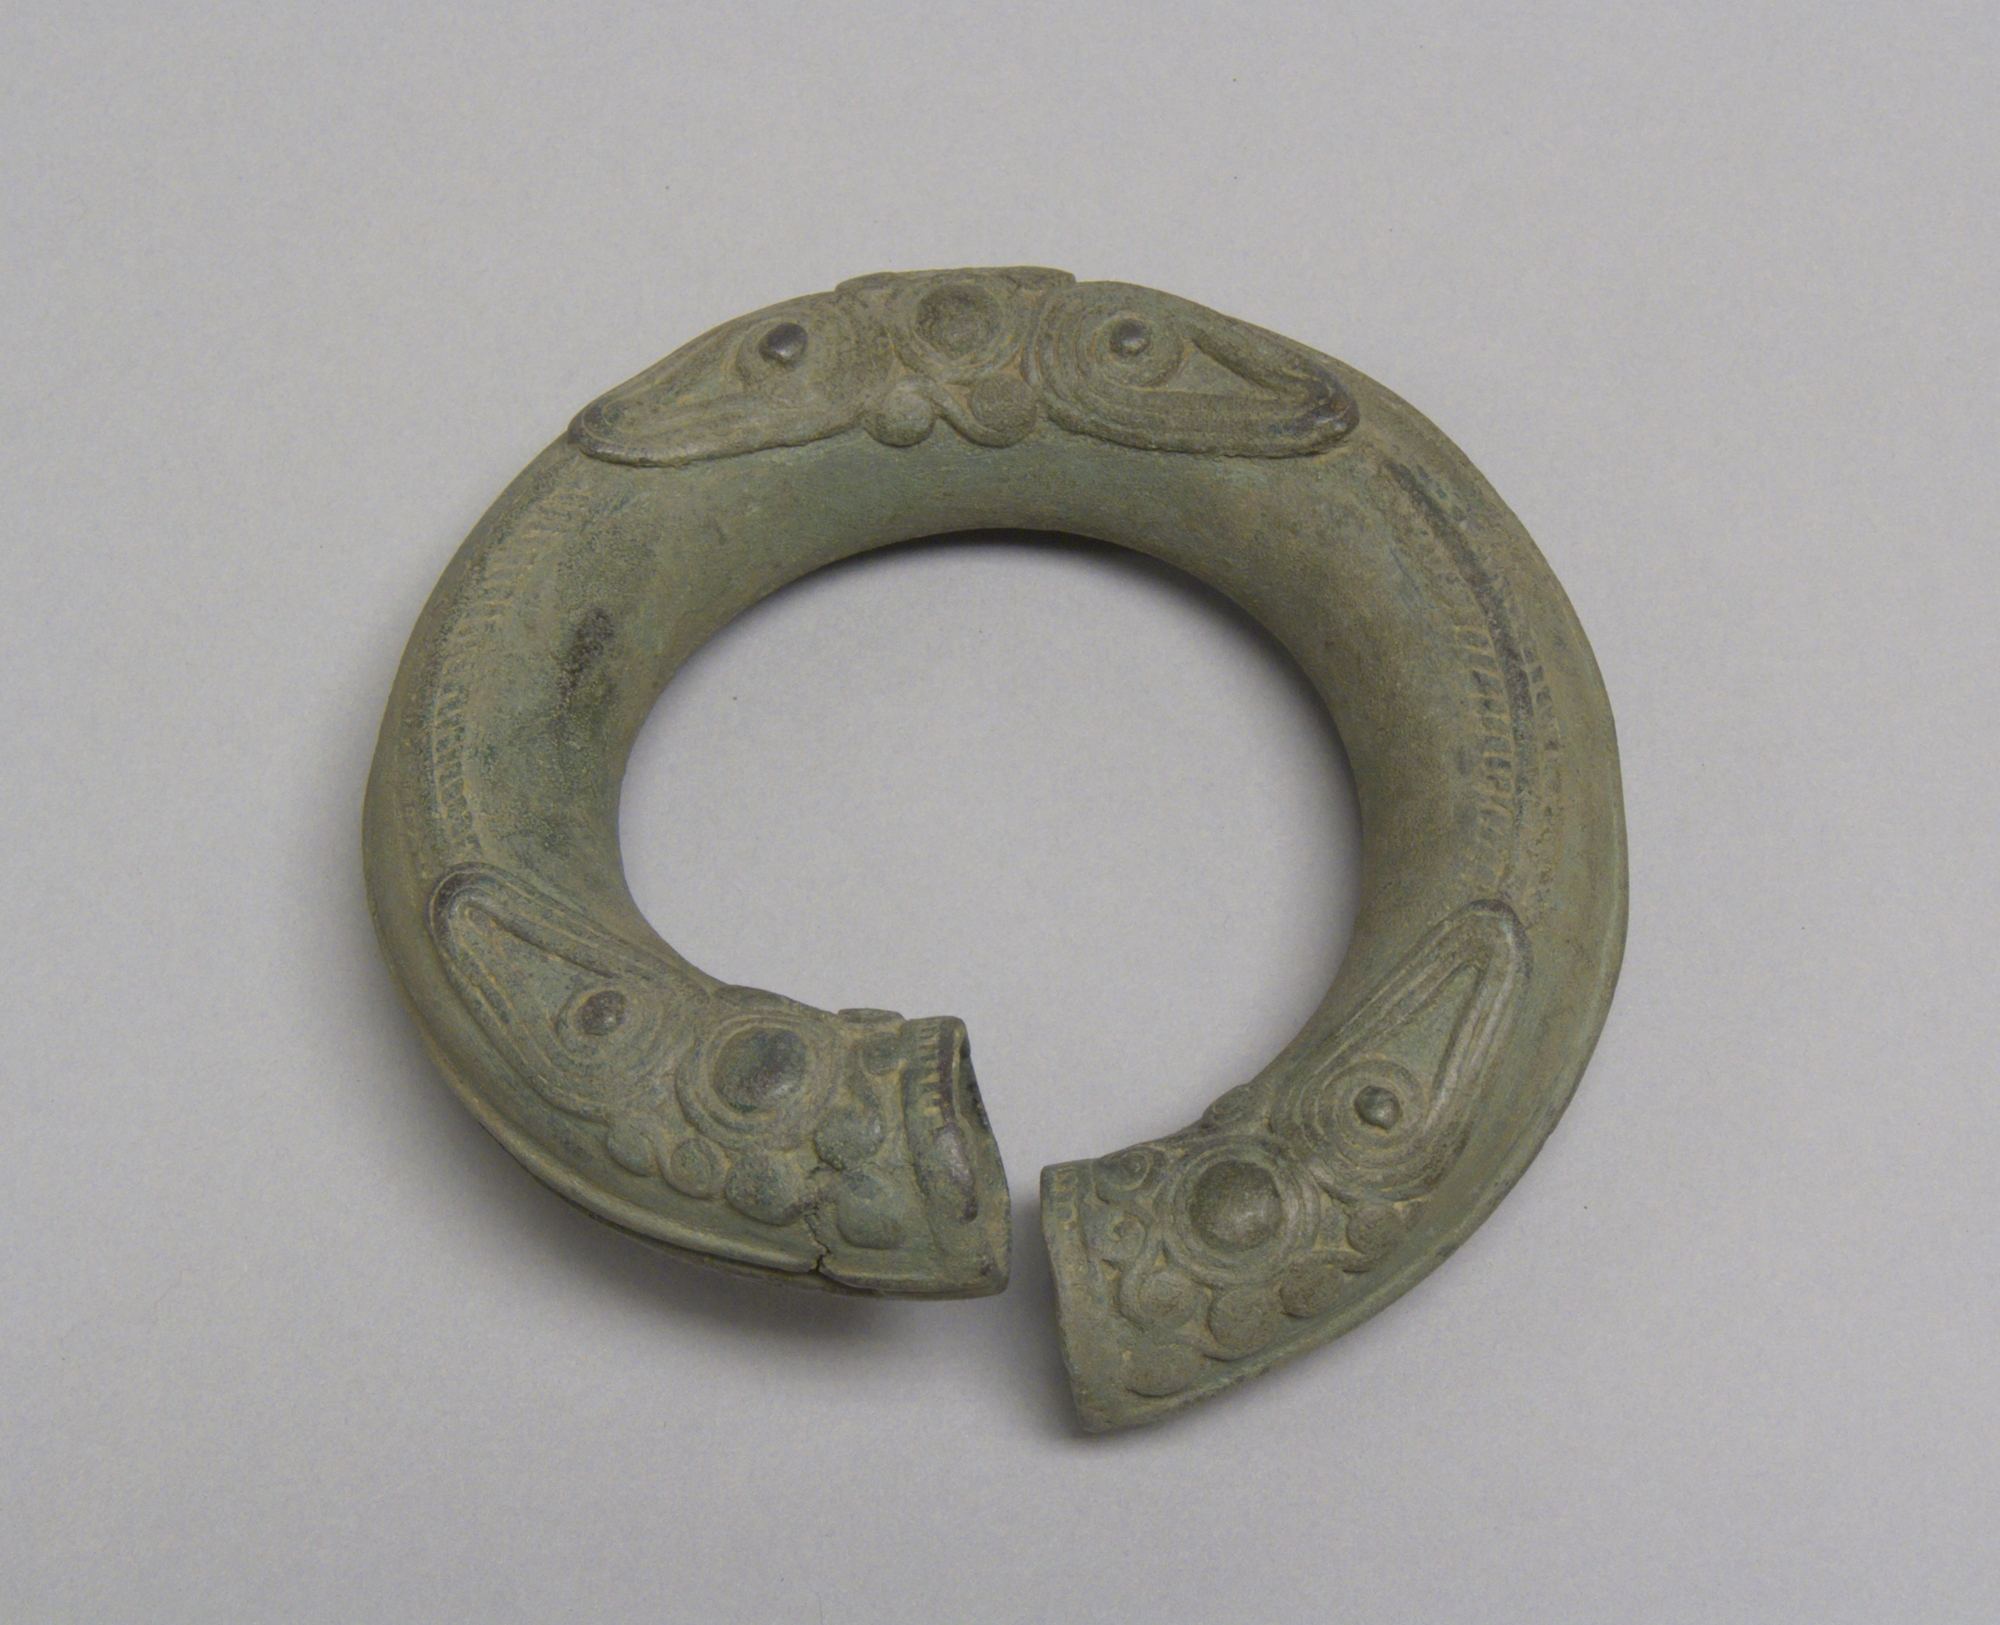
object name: anklet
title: Hollow Torqued Anklet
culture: thai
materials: bronze